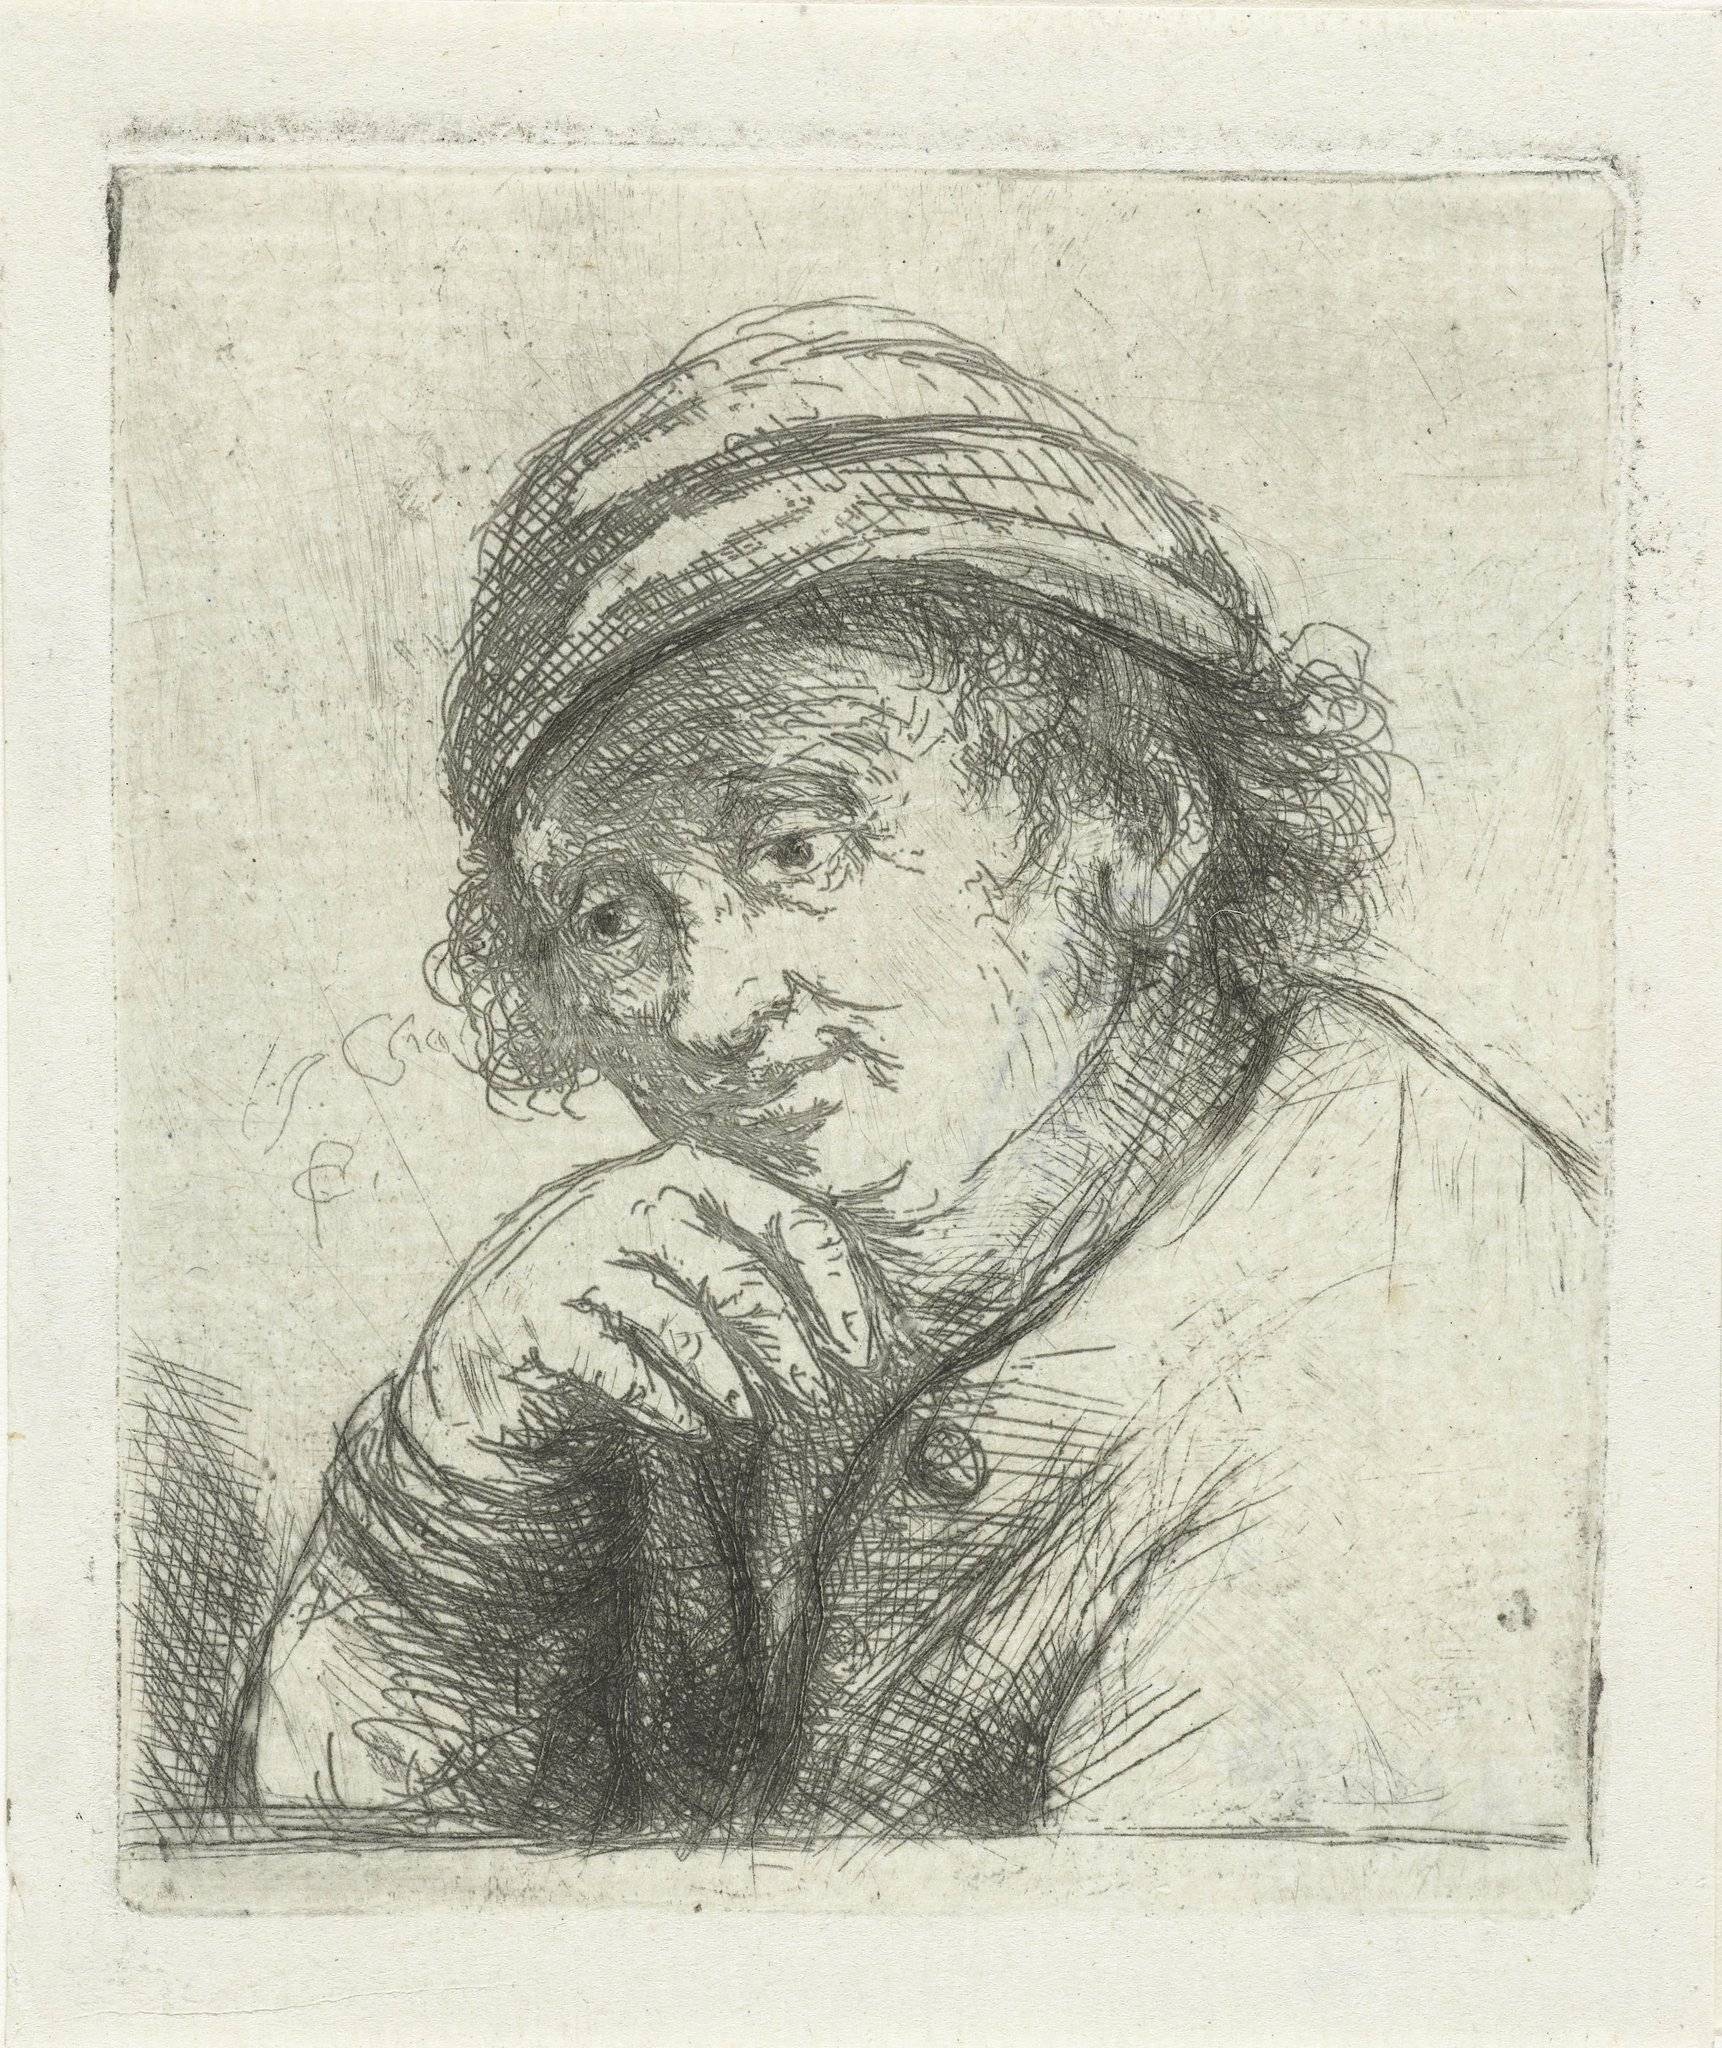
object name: print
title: Man met muts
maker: jan chalon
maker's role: print maker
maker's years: 1738-1795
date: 1748-1795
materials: paper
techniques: drypoint, etching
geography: northern netherlands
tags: head-gear: cap (+ men's clothes), morphology of human expression (+ adult male (human being))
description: Een volwassen man met muts. Buste naar links.